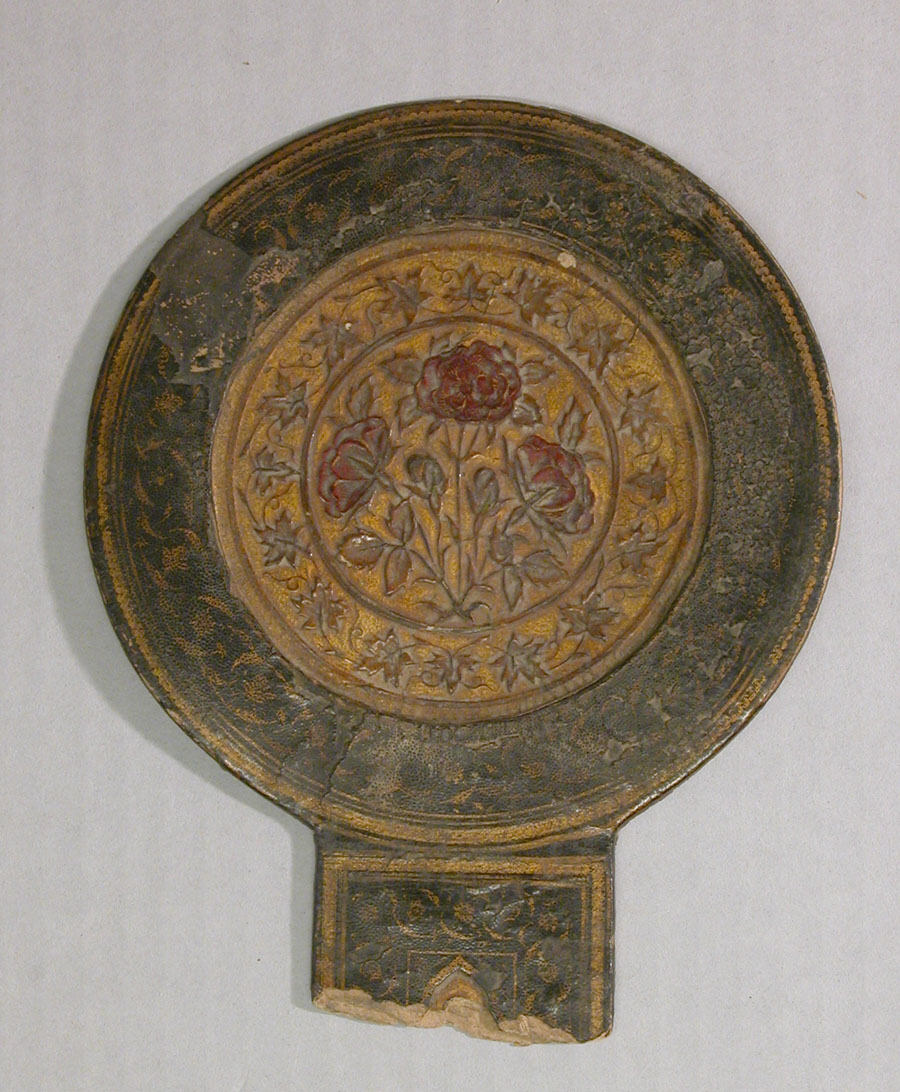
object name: mirror case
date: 1601-1700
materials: leather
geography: iran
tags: flowers